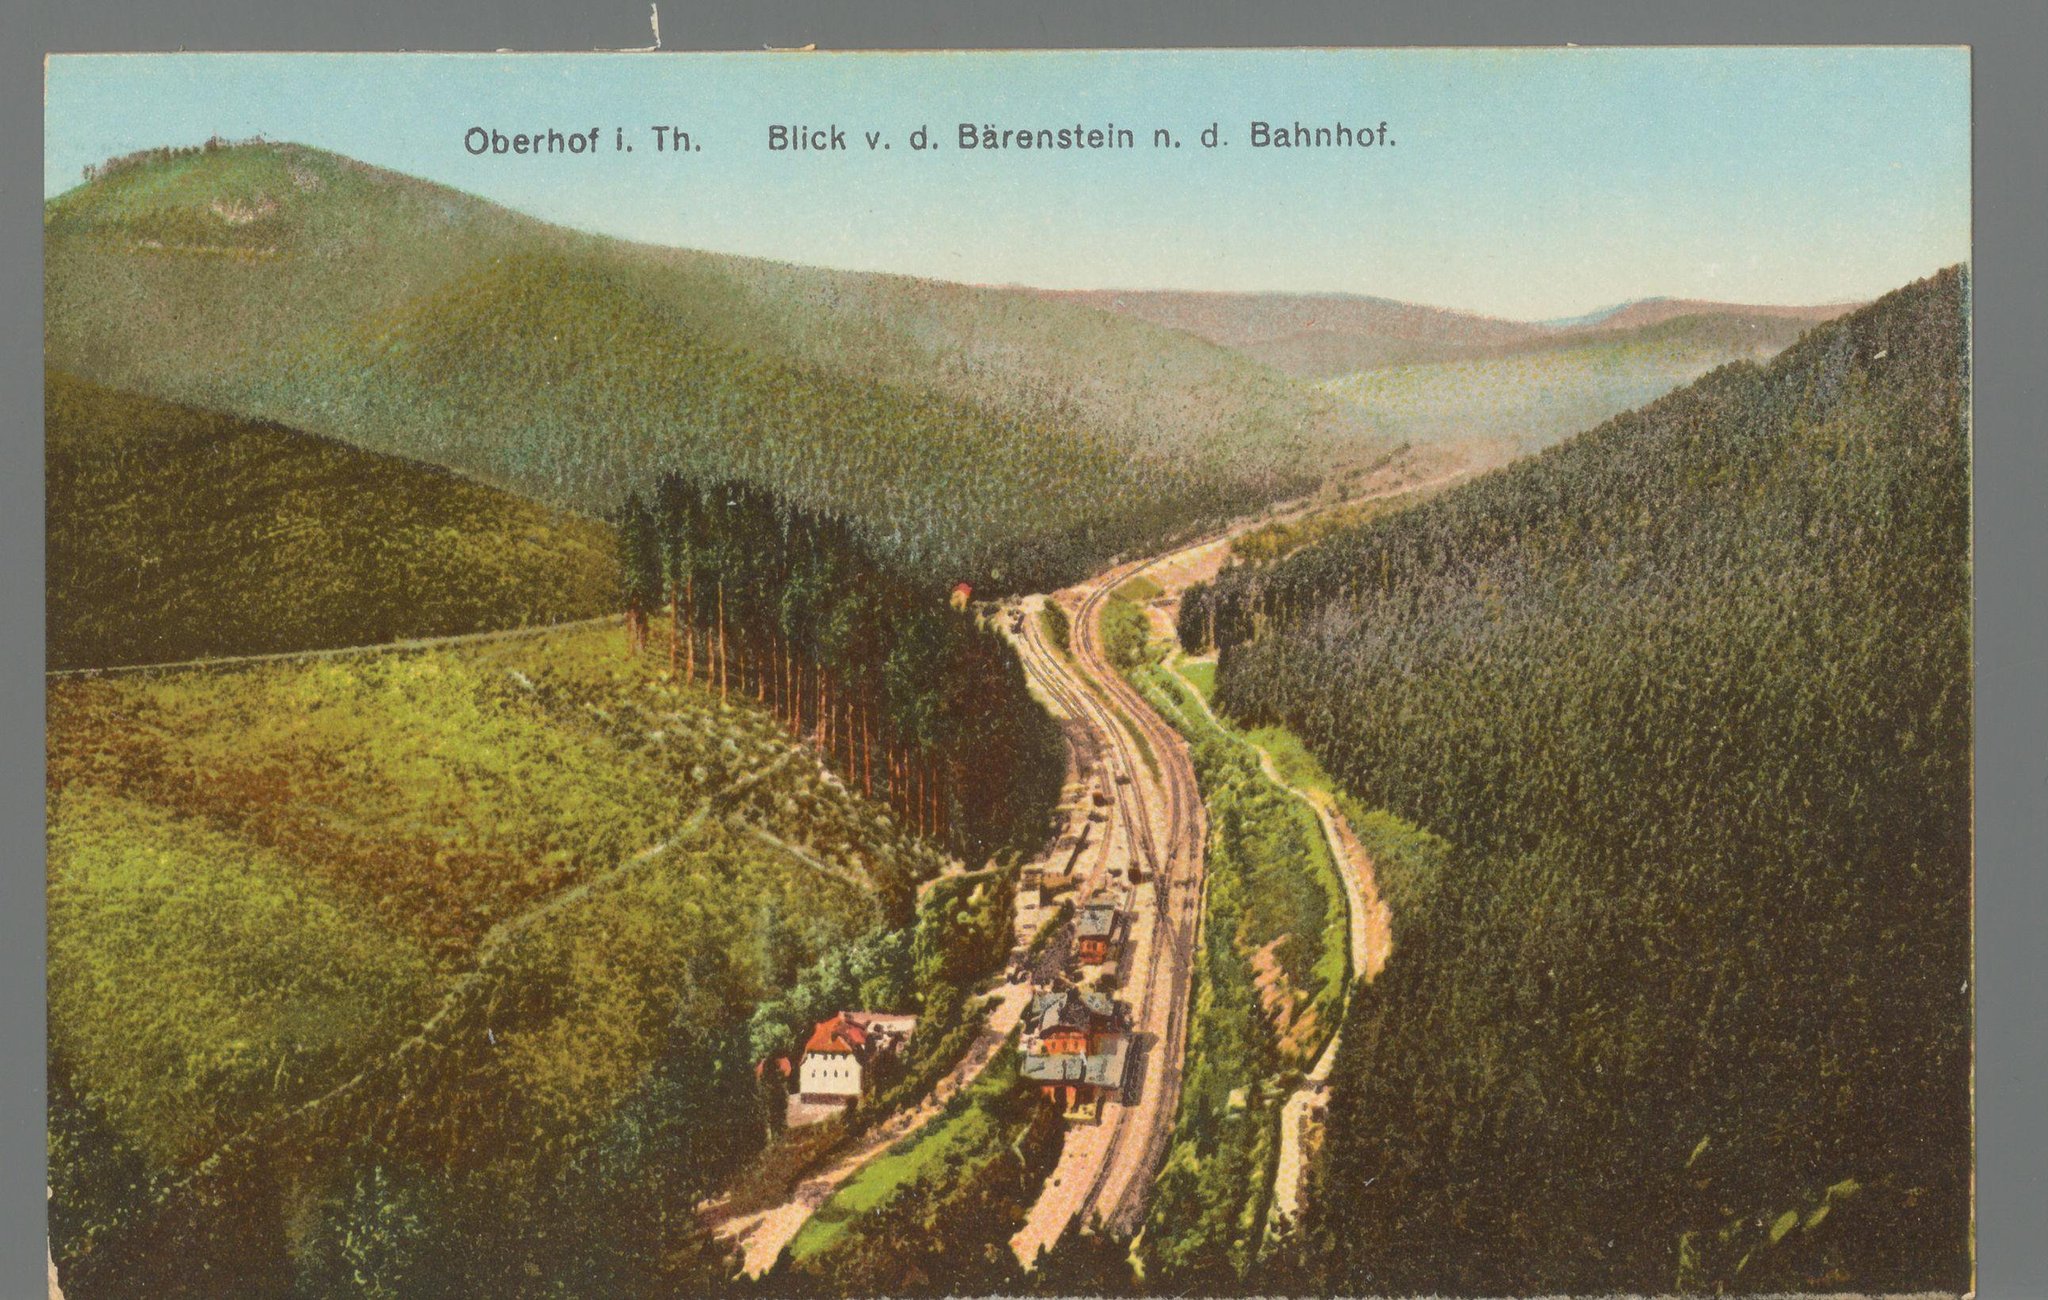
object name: print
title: Oberhof i. Th. Blick v. d. Bärenstein n. d. Bahnhof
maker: Anonymous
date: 1910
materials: cardboard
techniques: lithograph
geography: oberhof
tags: station; shelter (railway, tramway), mountains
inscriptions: date